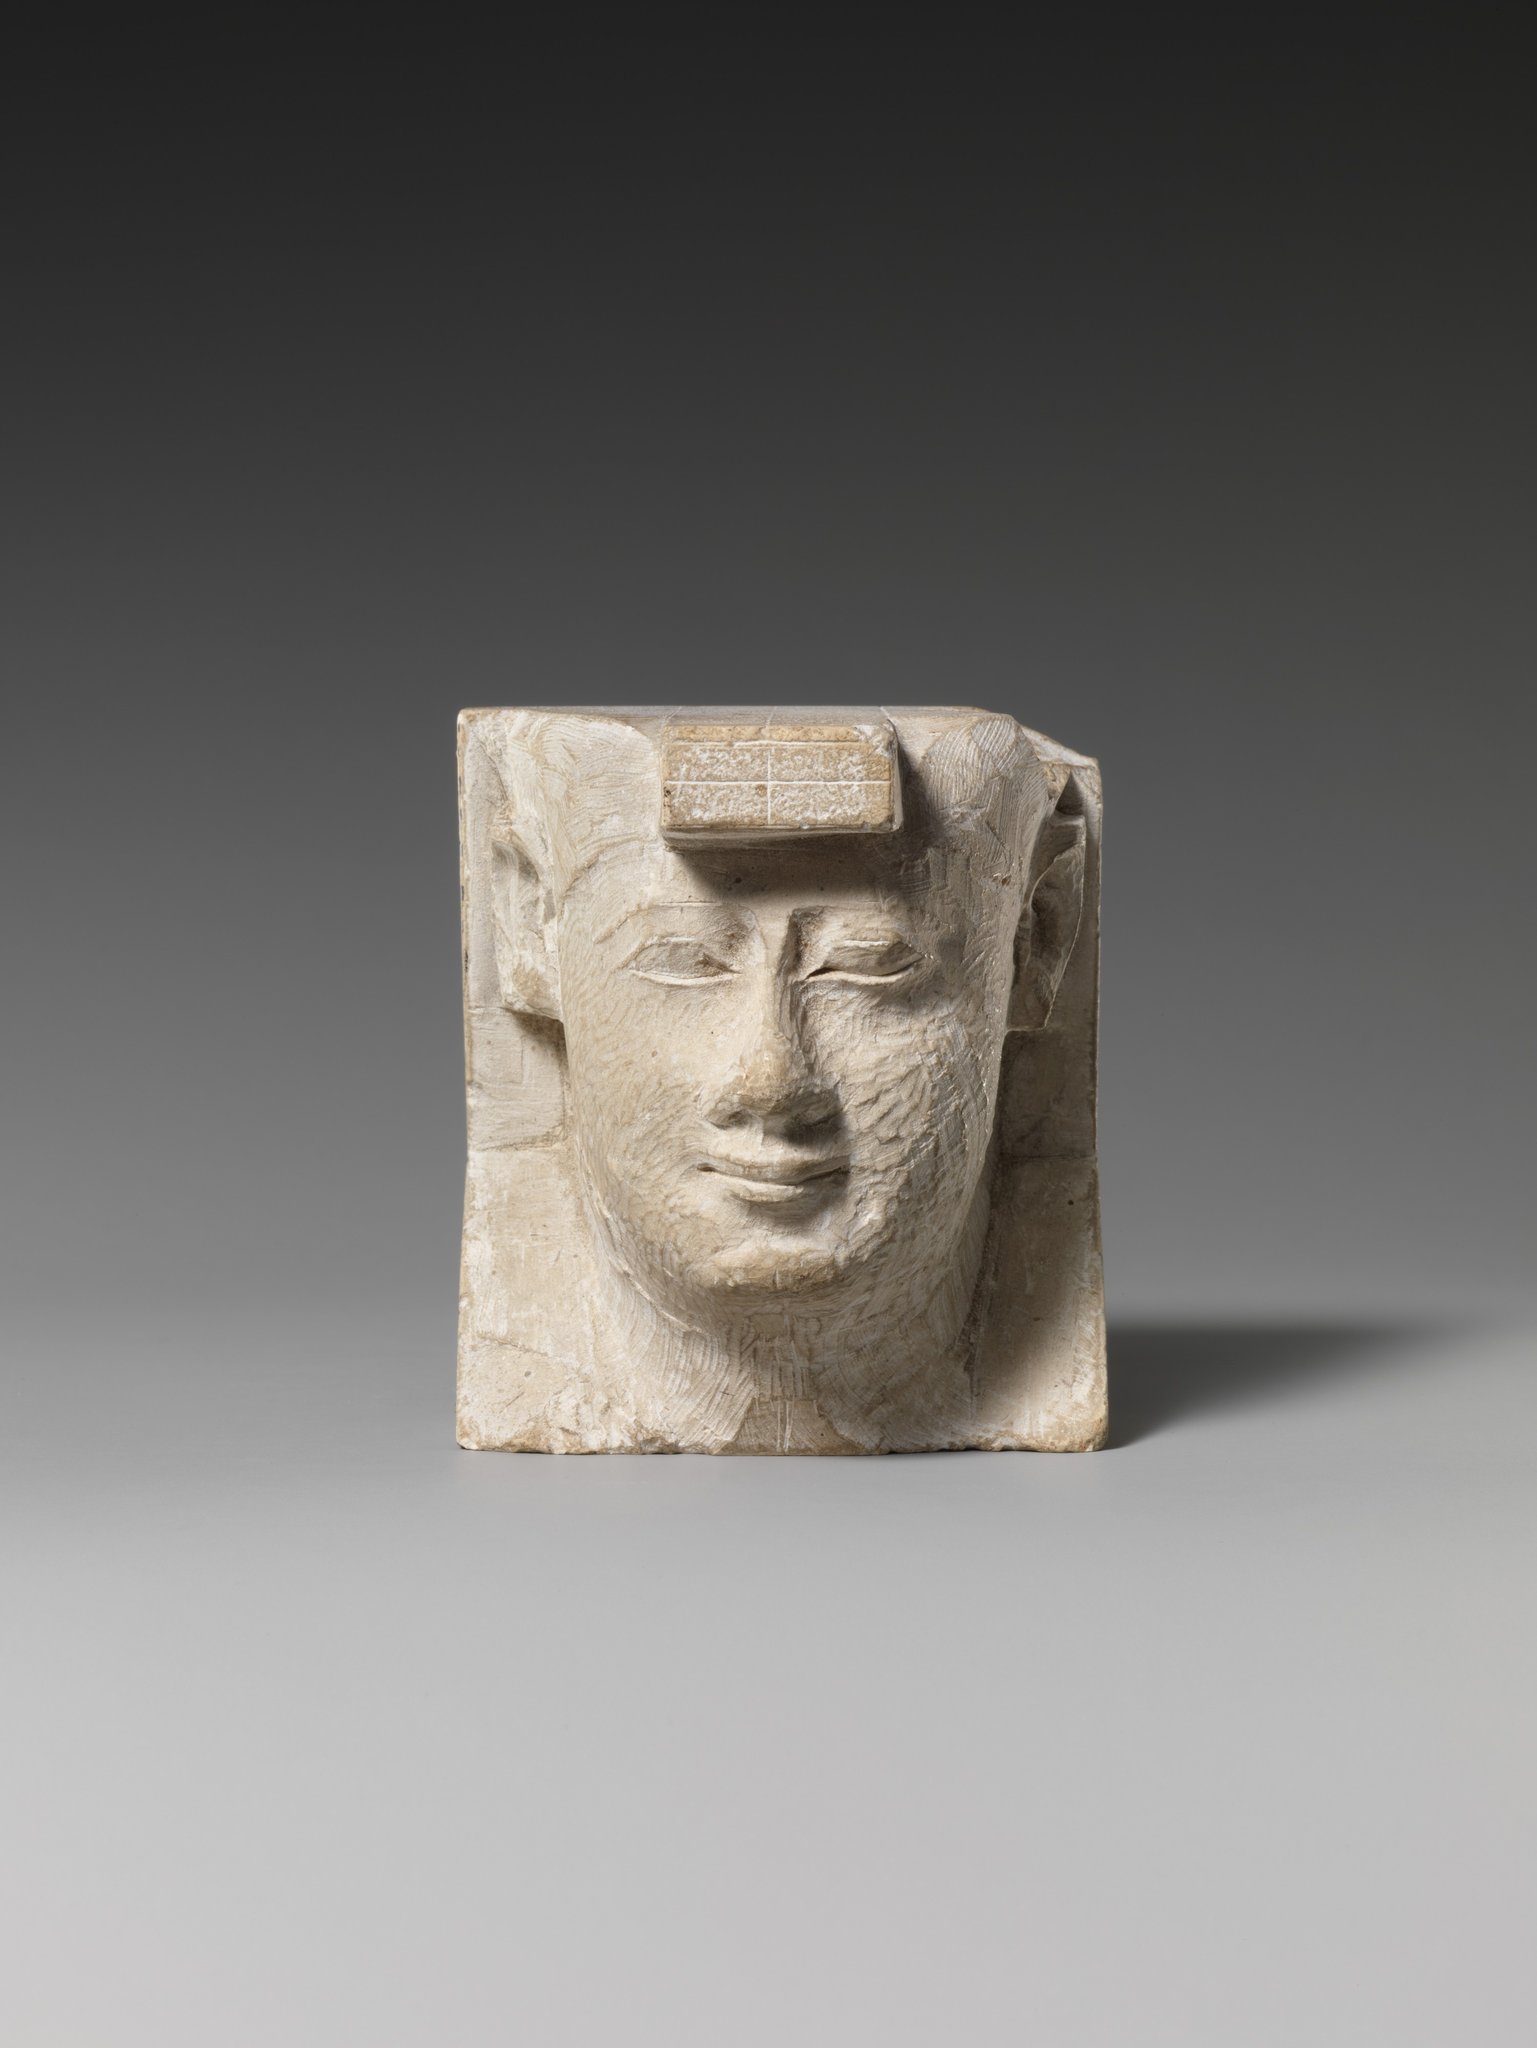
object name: sculptor's model votive, royal bust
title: Royal bust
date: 400-200 BCE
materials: limestone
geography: egypt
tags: faces